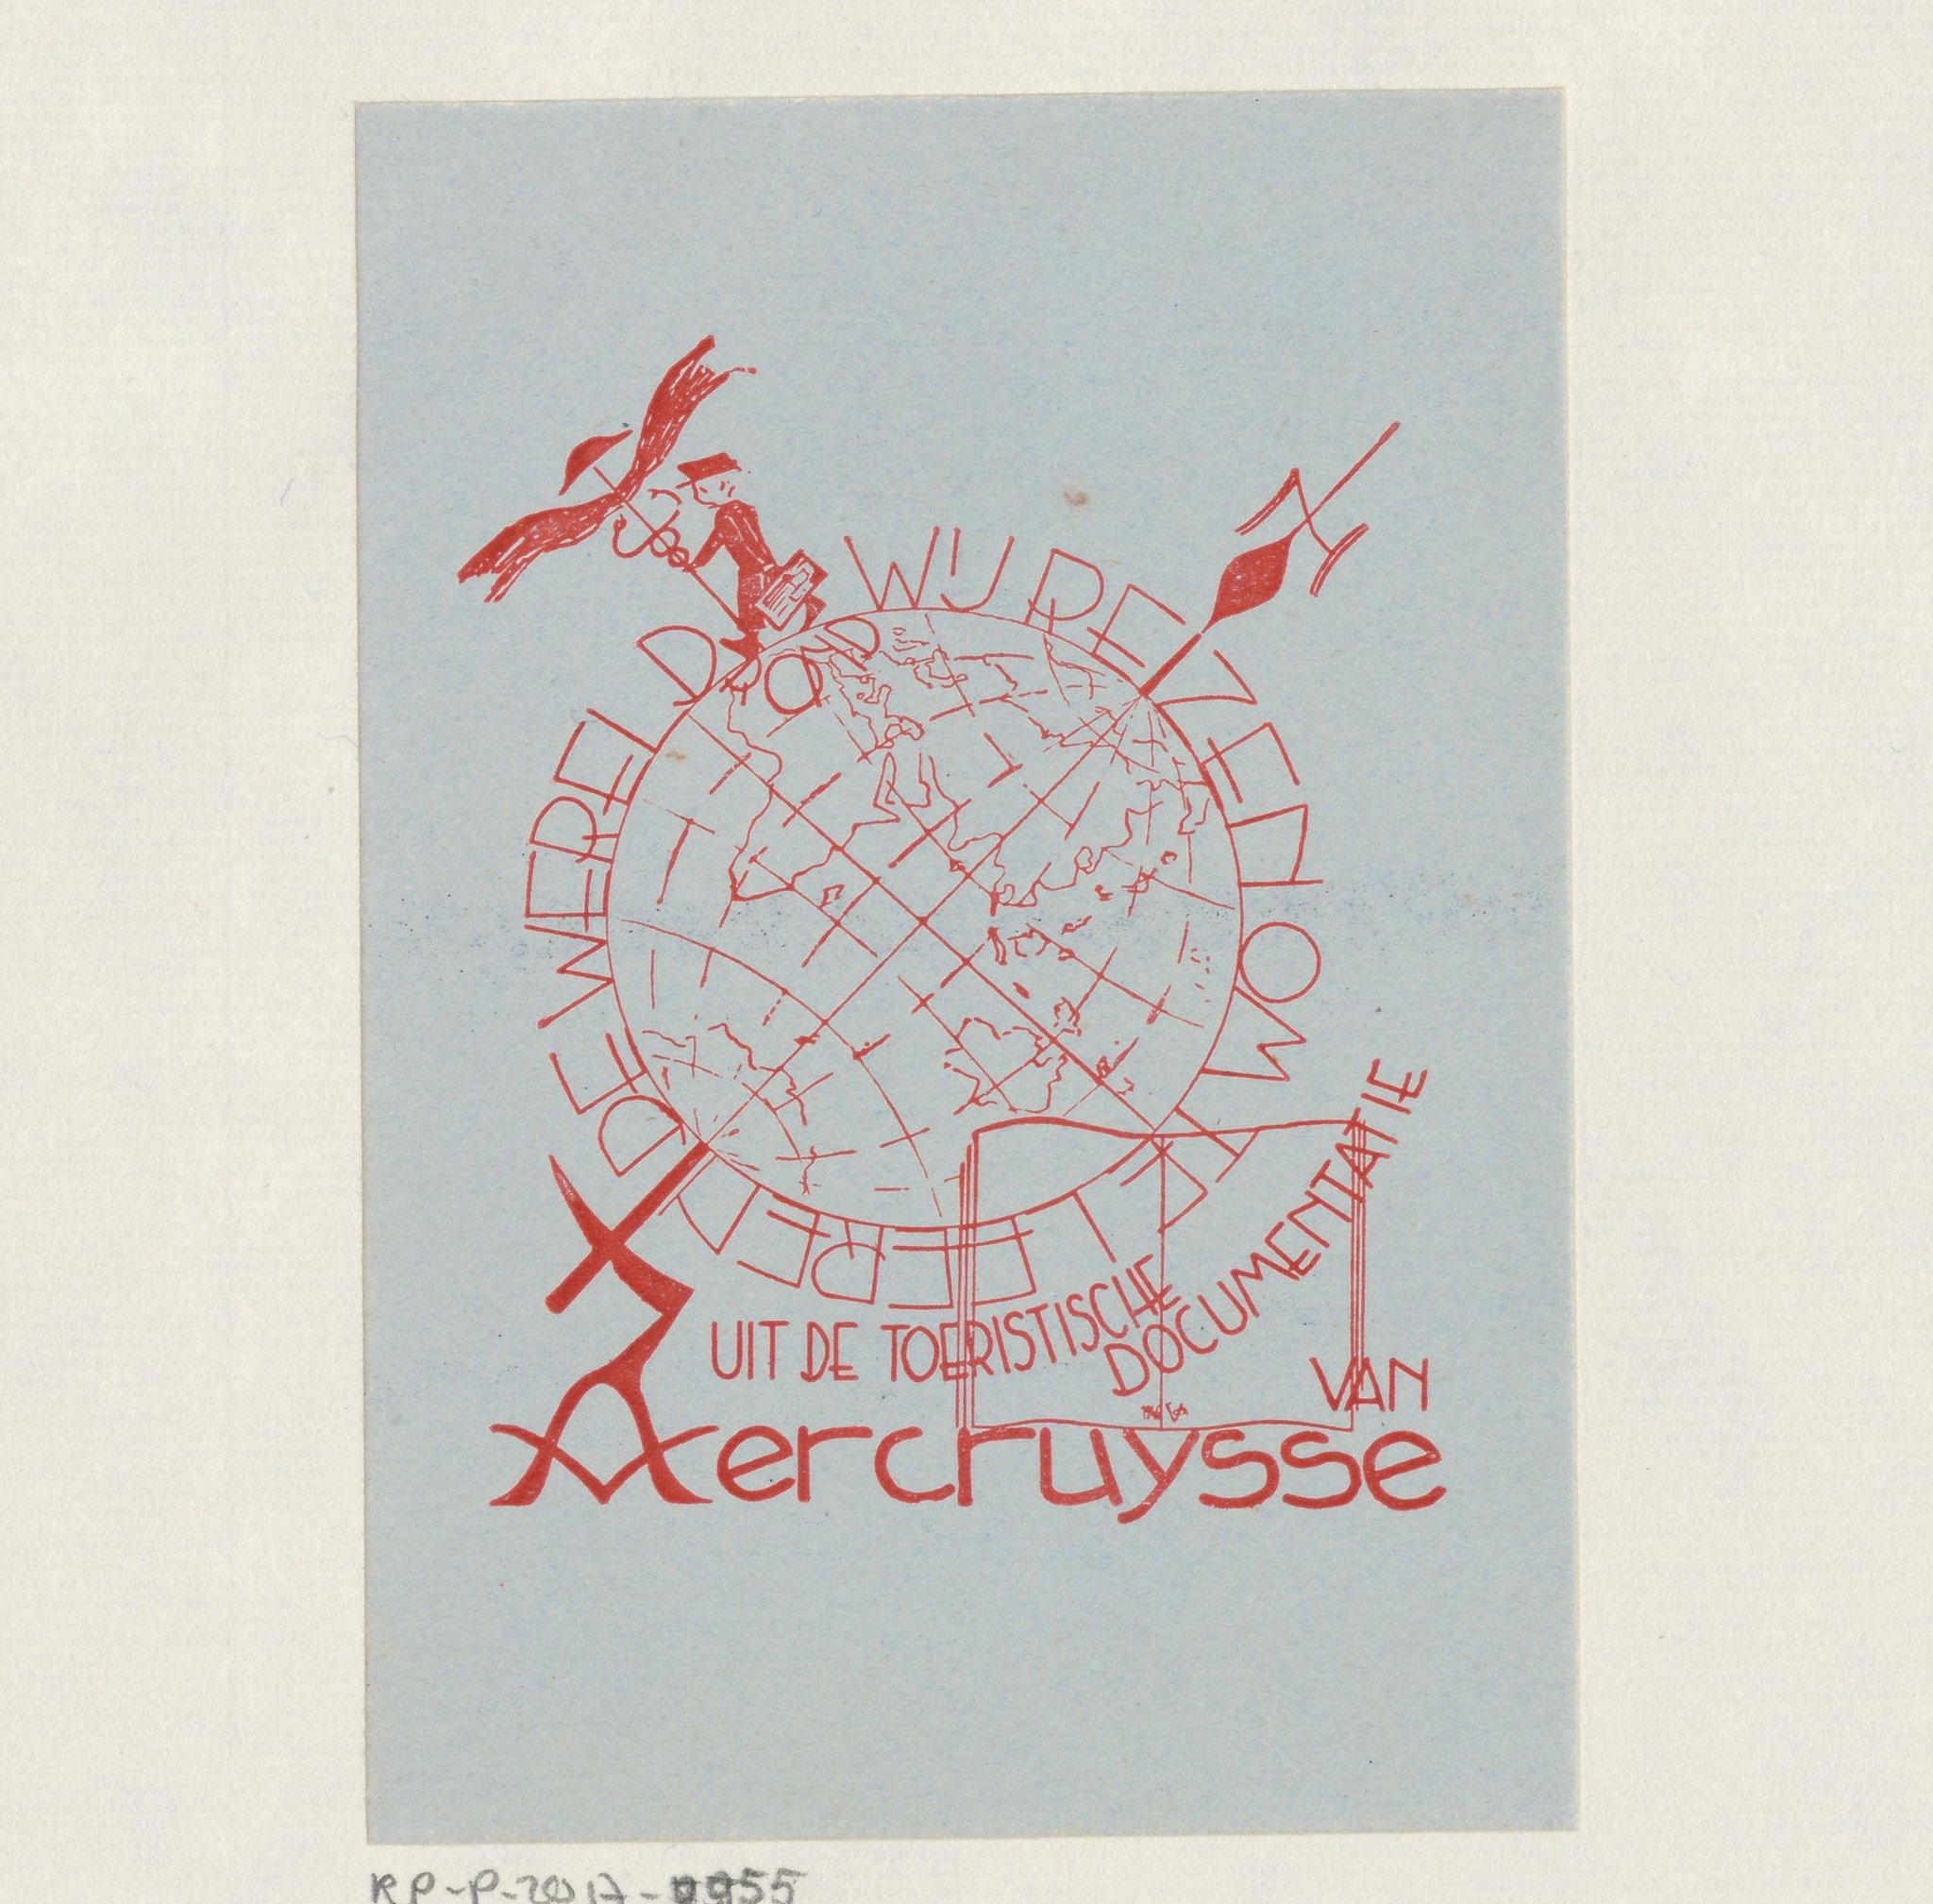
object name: bookplate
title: Uit de toeristische documentatie van A. Vercruysse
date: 1946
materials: paper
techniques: printing block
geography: belgium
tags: print maker, albert vercruysse, typewriter, caduceus (staff with two snakes, attribute of mercury), globe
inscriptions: inscription: ‘[...] A. Vercruysse/ Deinze België/ fecit 1946/ Zink’